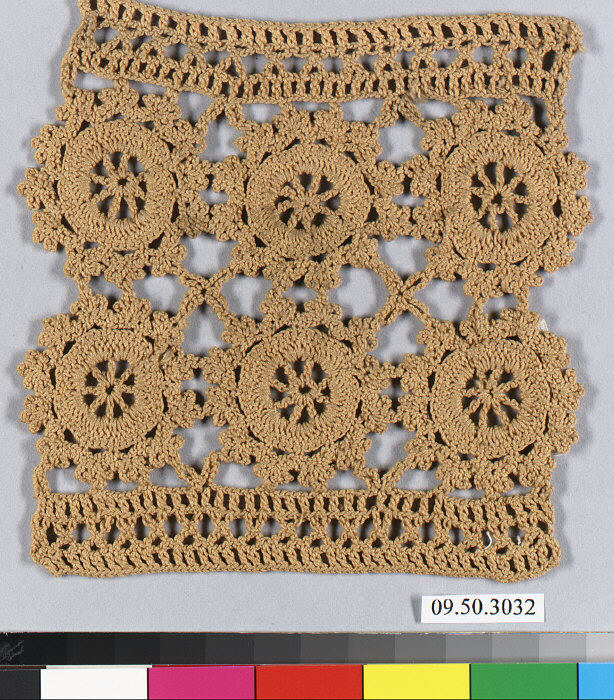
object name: sample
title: Crochet Work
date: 1801-1900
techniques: crochet